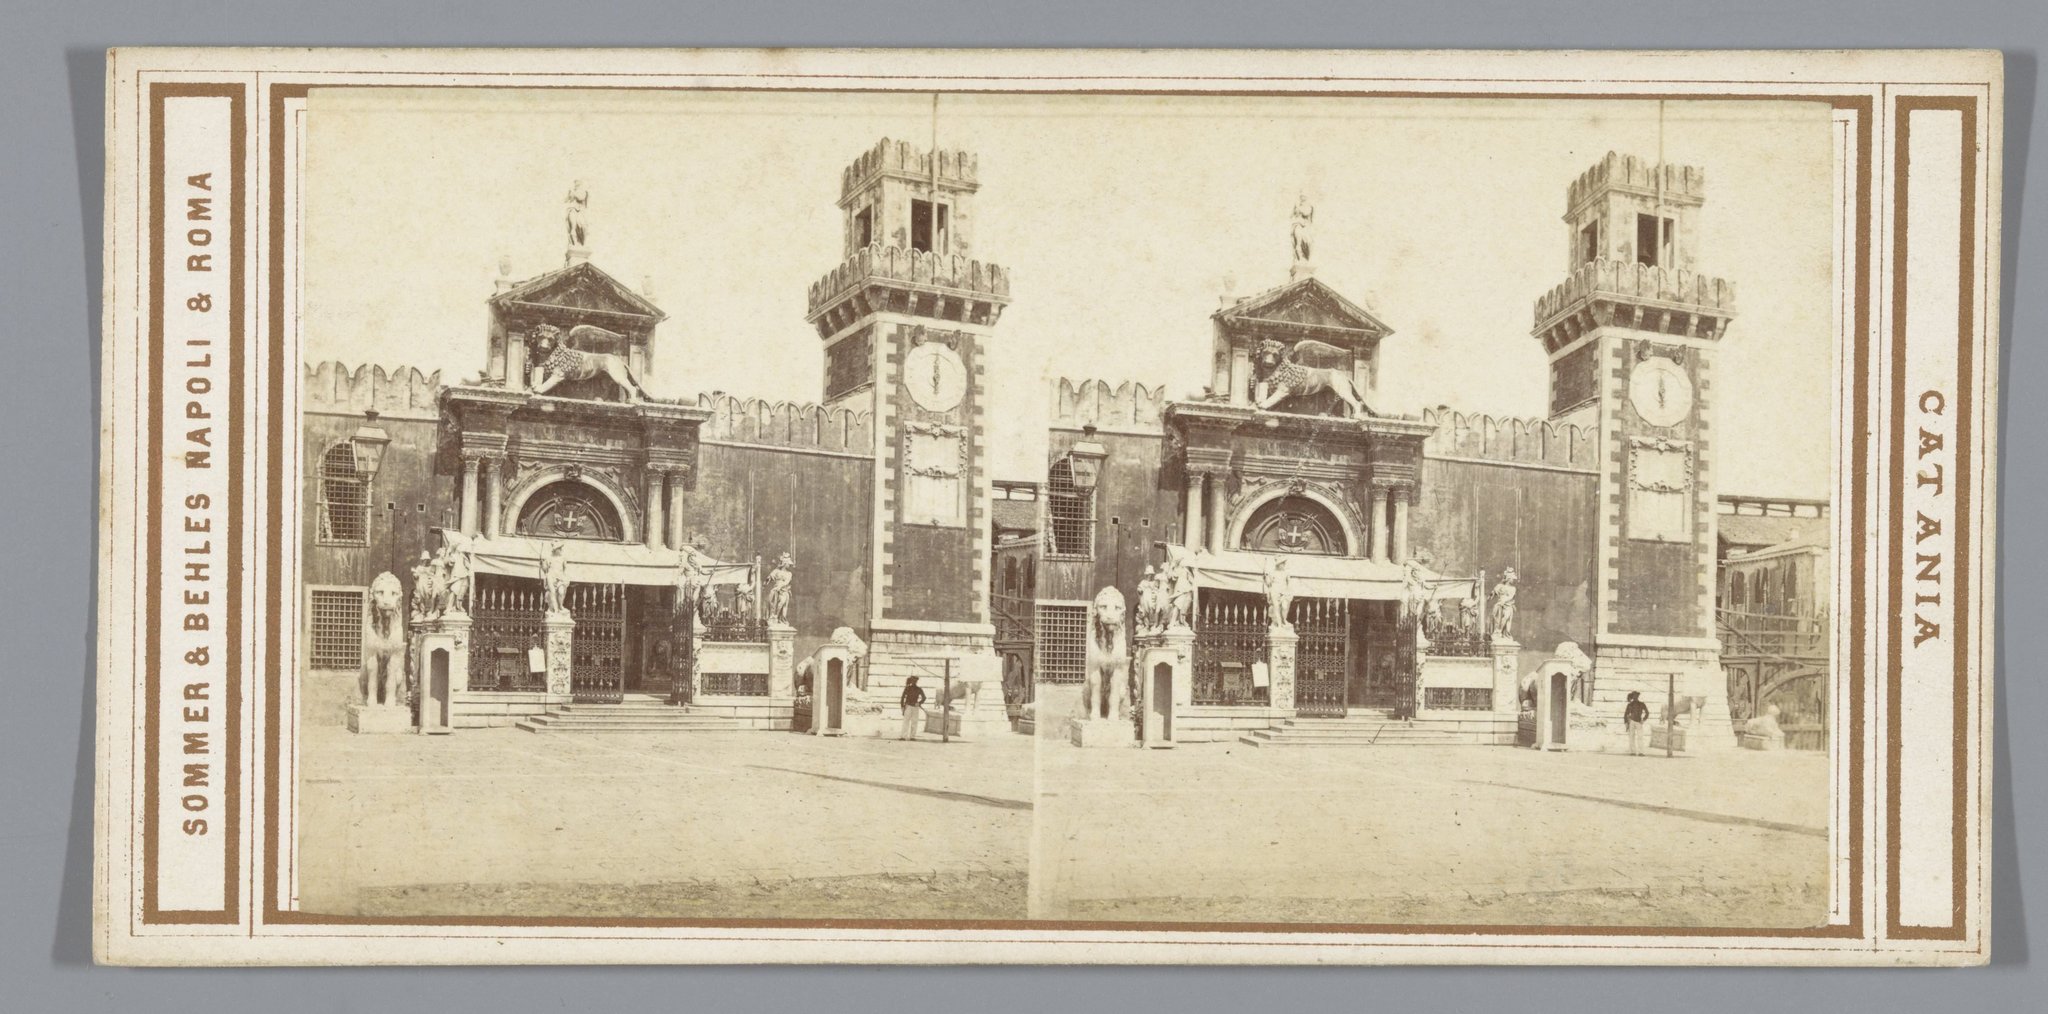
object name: stereograph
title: Catania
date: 1860-1880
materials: cardboard, photographic support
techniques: albumen print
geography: venice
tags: gate, entrance